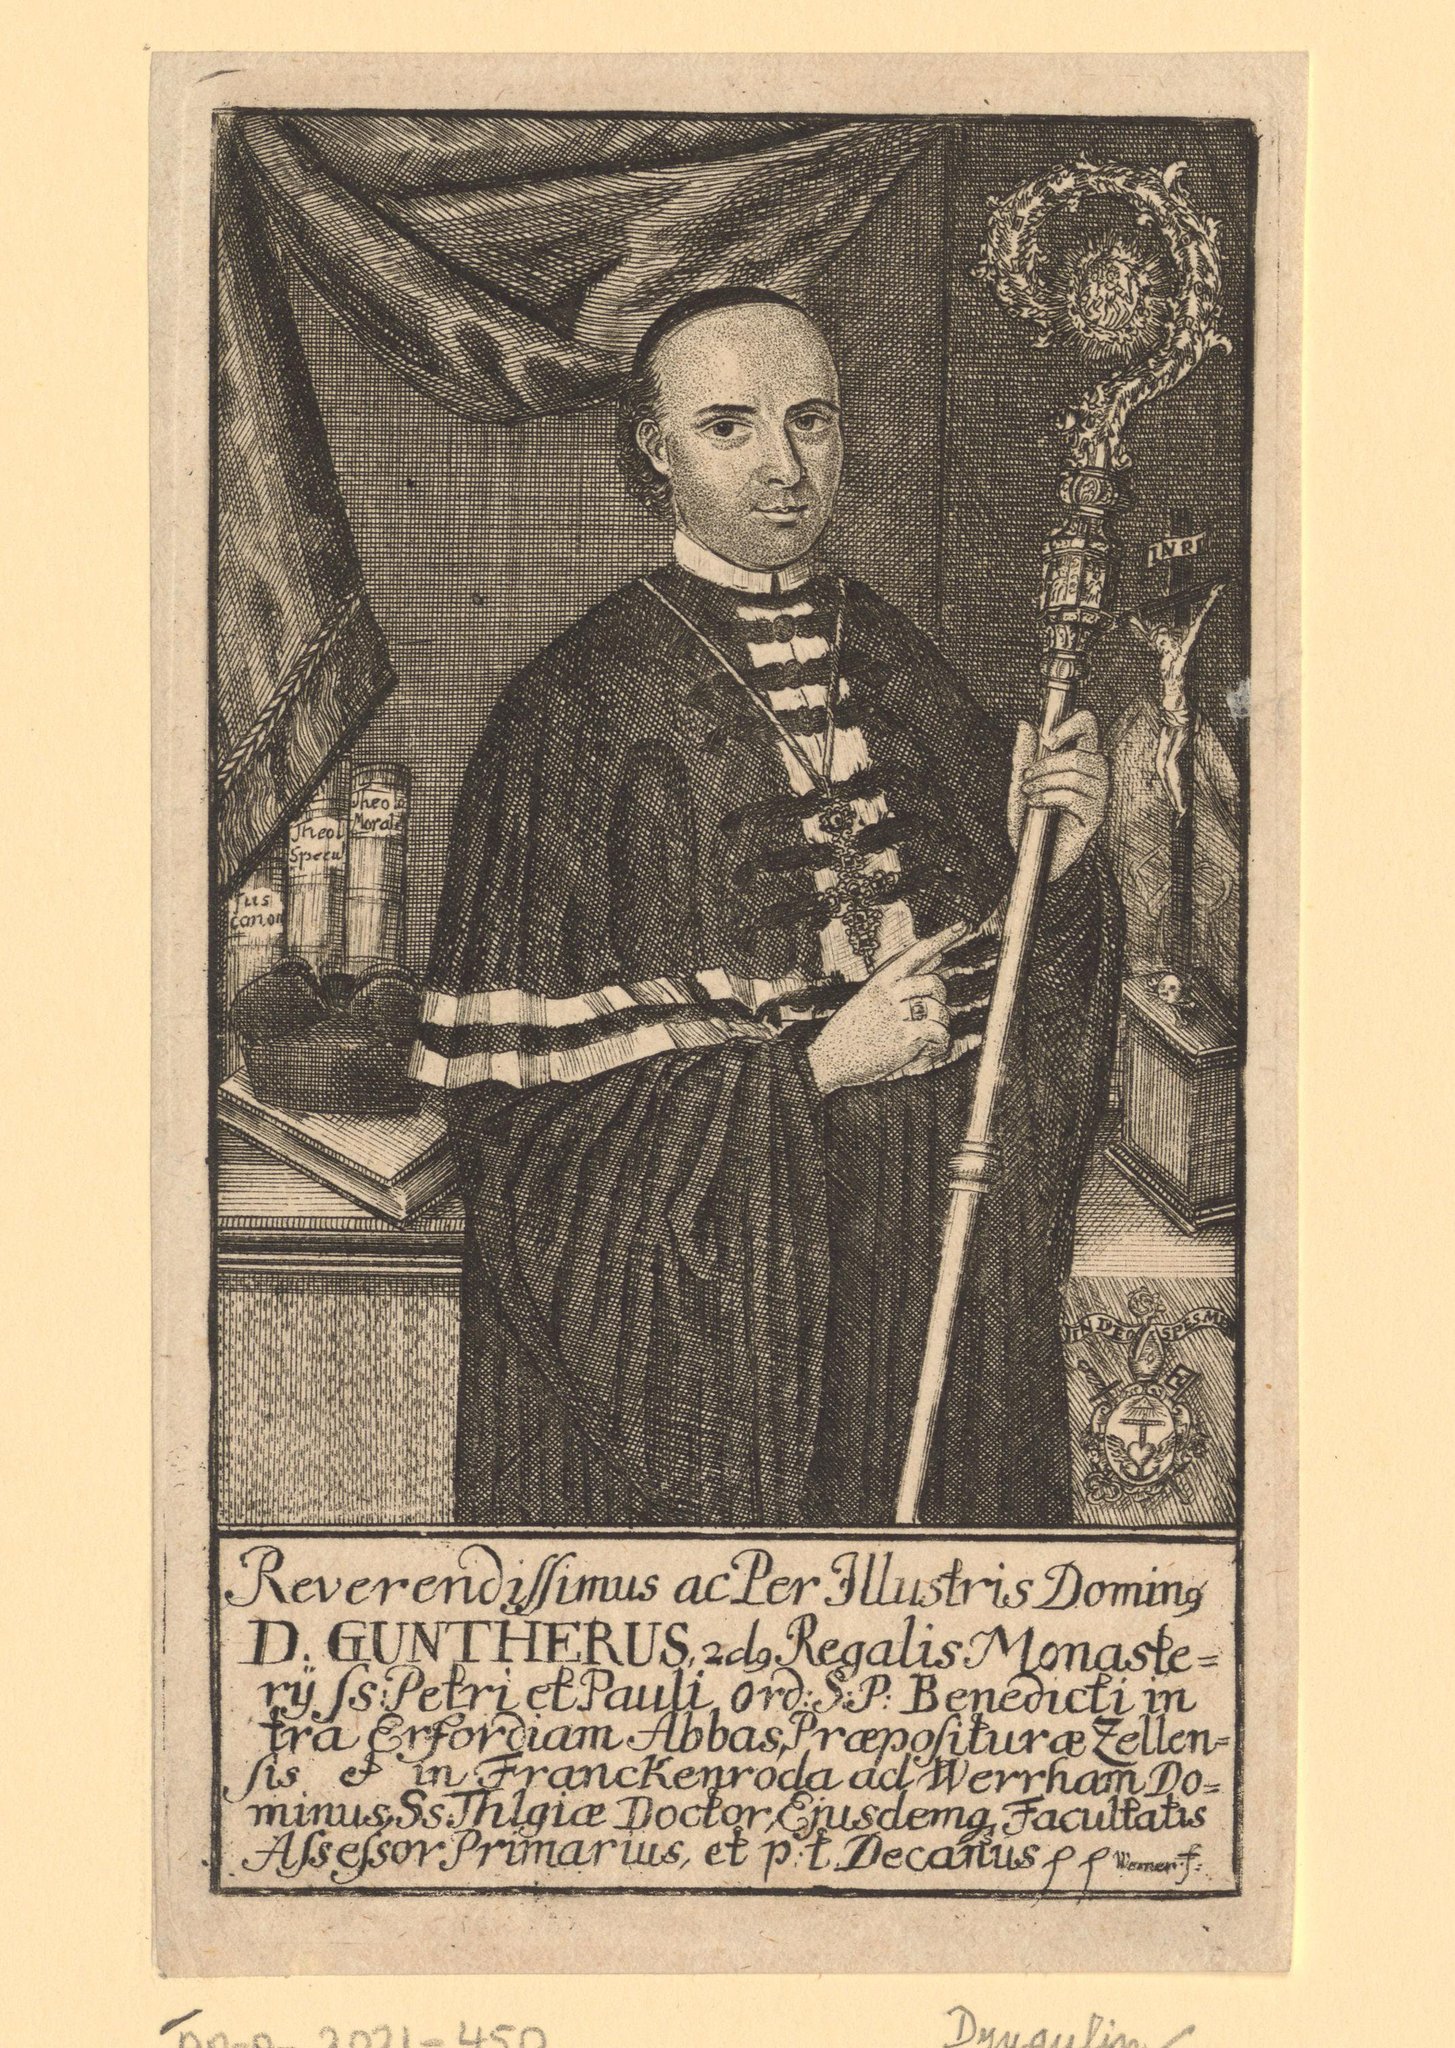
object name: print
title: Portret van Günther Jann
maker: georg heinrich werner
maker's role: print maker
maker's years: 1723-1789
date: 1738-1820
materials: paper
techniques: engraving, etching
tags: theologian, historical persons